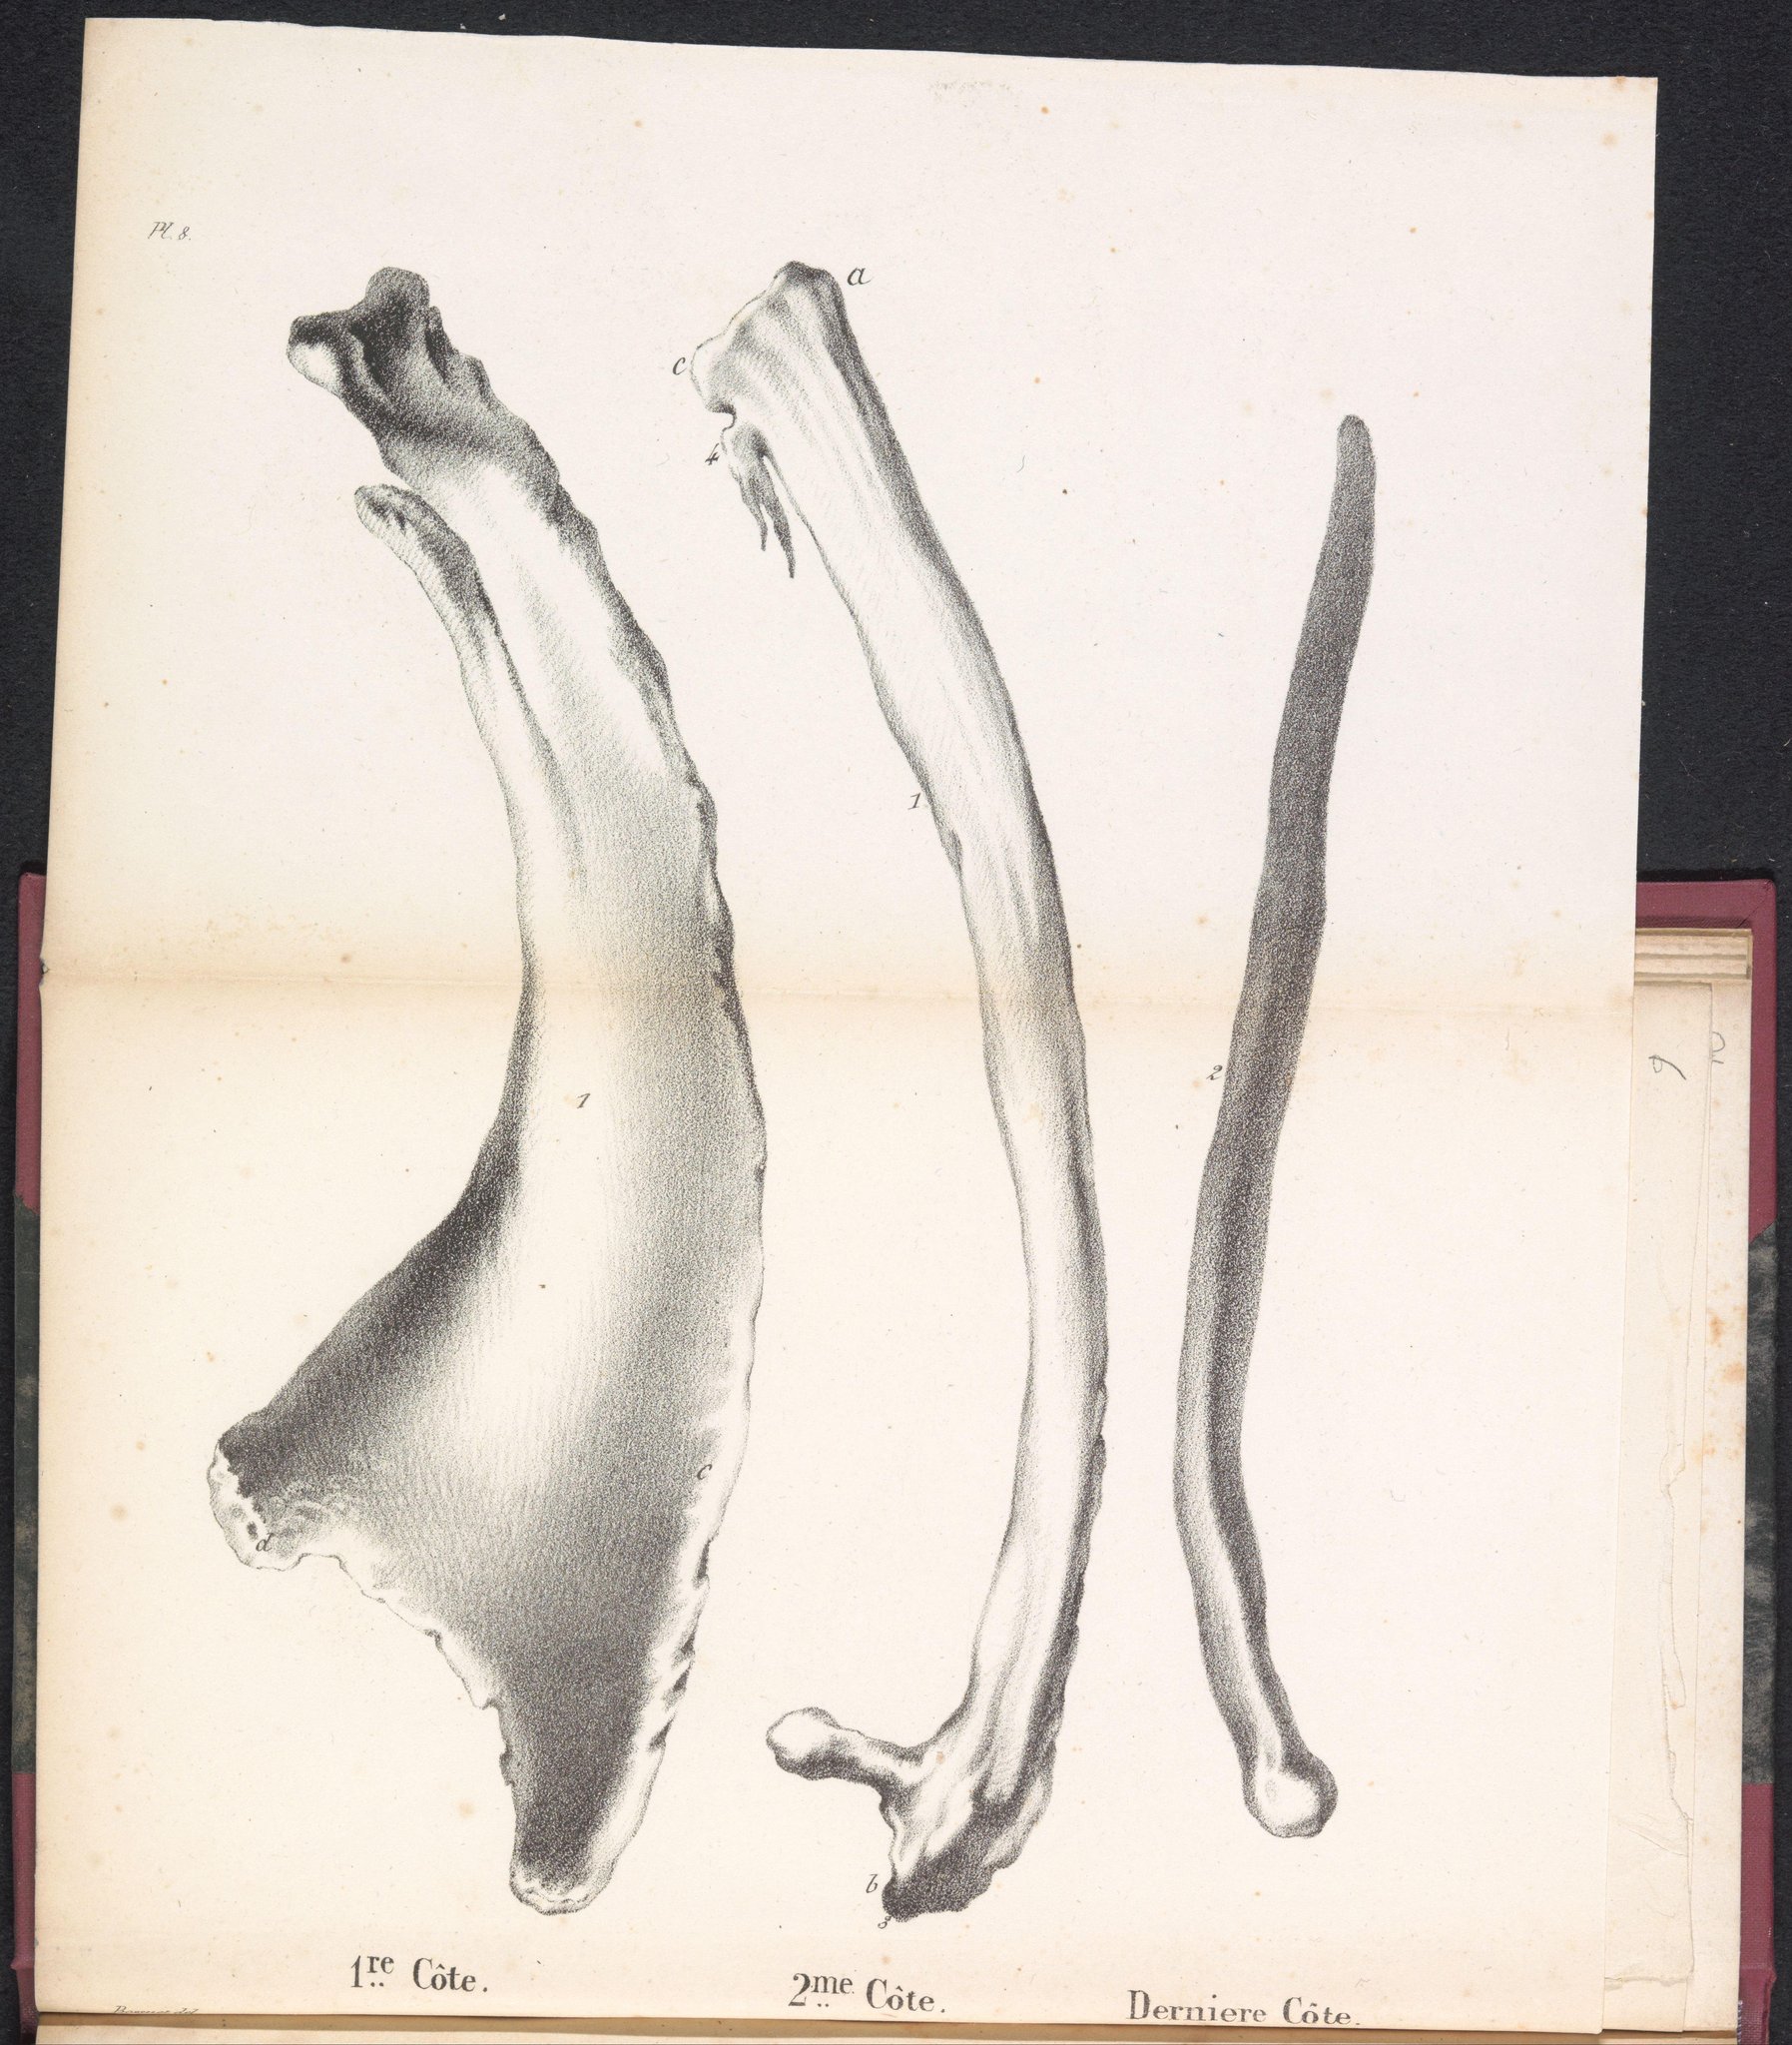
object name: print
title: Drie ribben van de walvis, 1827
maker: jean baptiste ambroise marcellin jobard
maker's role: print maker, publisher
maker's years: 1792-1861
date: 1828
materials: paper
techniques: lithograph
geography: brussels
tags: herman kessels, swimming mammals: whale (+ dying animal; death of animal; dead animal)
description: Drie ribben van de walvis. Illustratie in een publicatie over de walvis gestrand op 4 november 1827 bij Oostende. De walvis was eigendom van H. Kessels en J. Dubar.